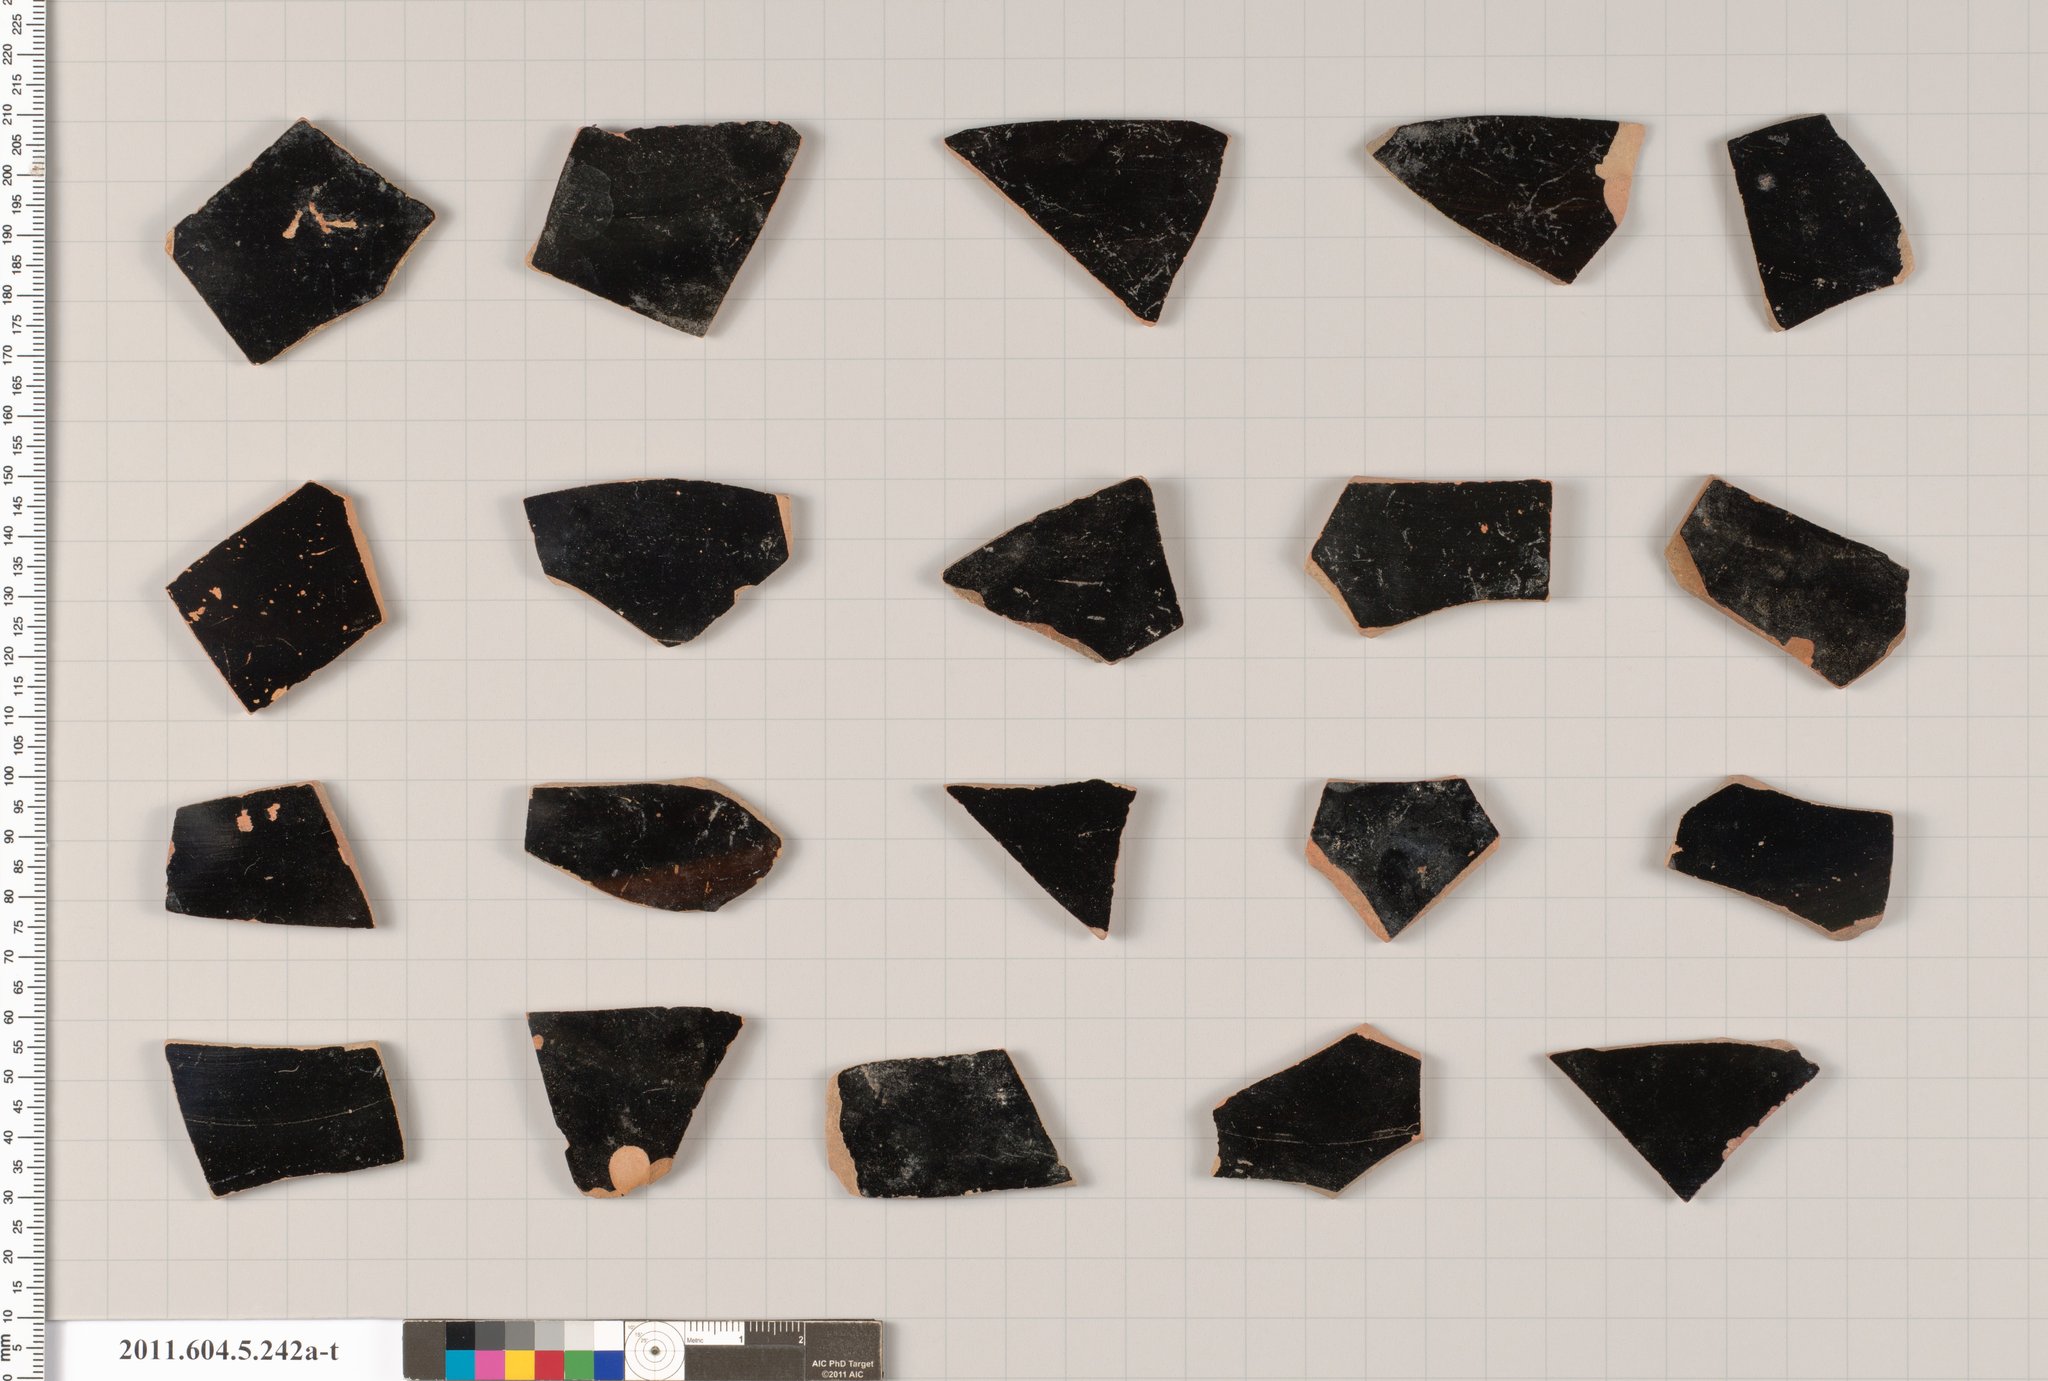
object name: kylix fragment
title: Terracotta fragments of kylikes (drinking cups)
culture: greek, attic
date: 600-401 BCE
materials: terracotta